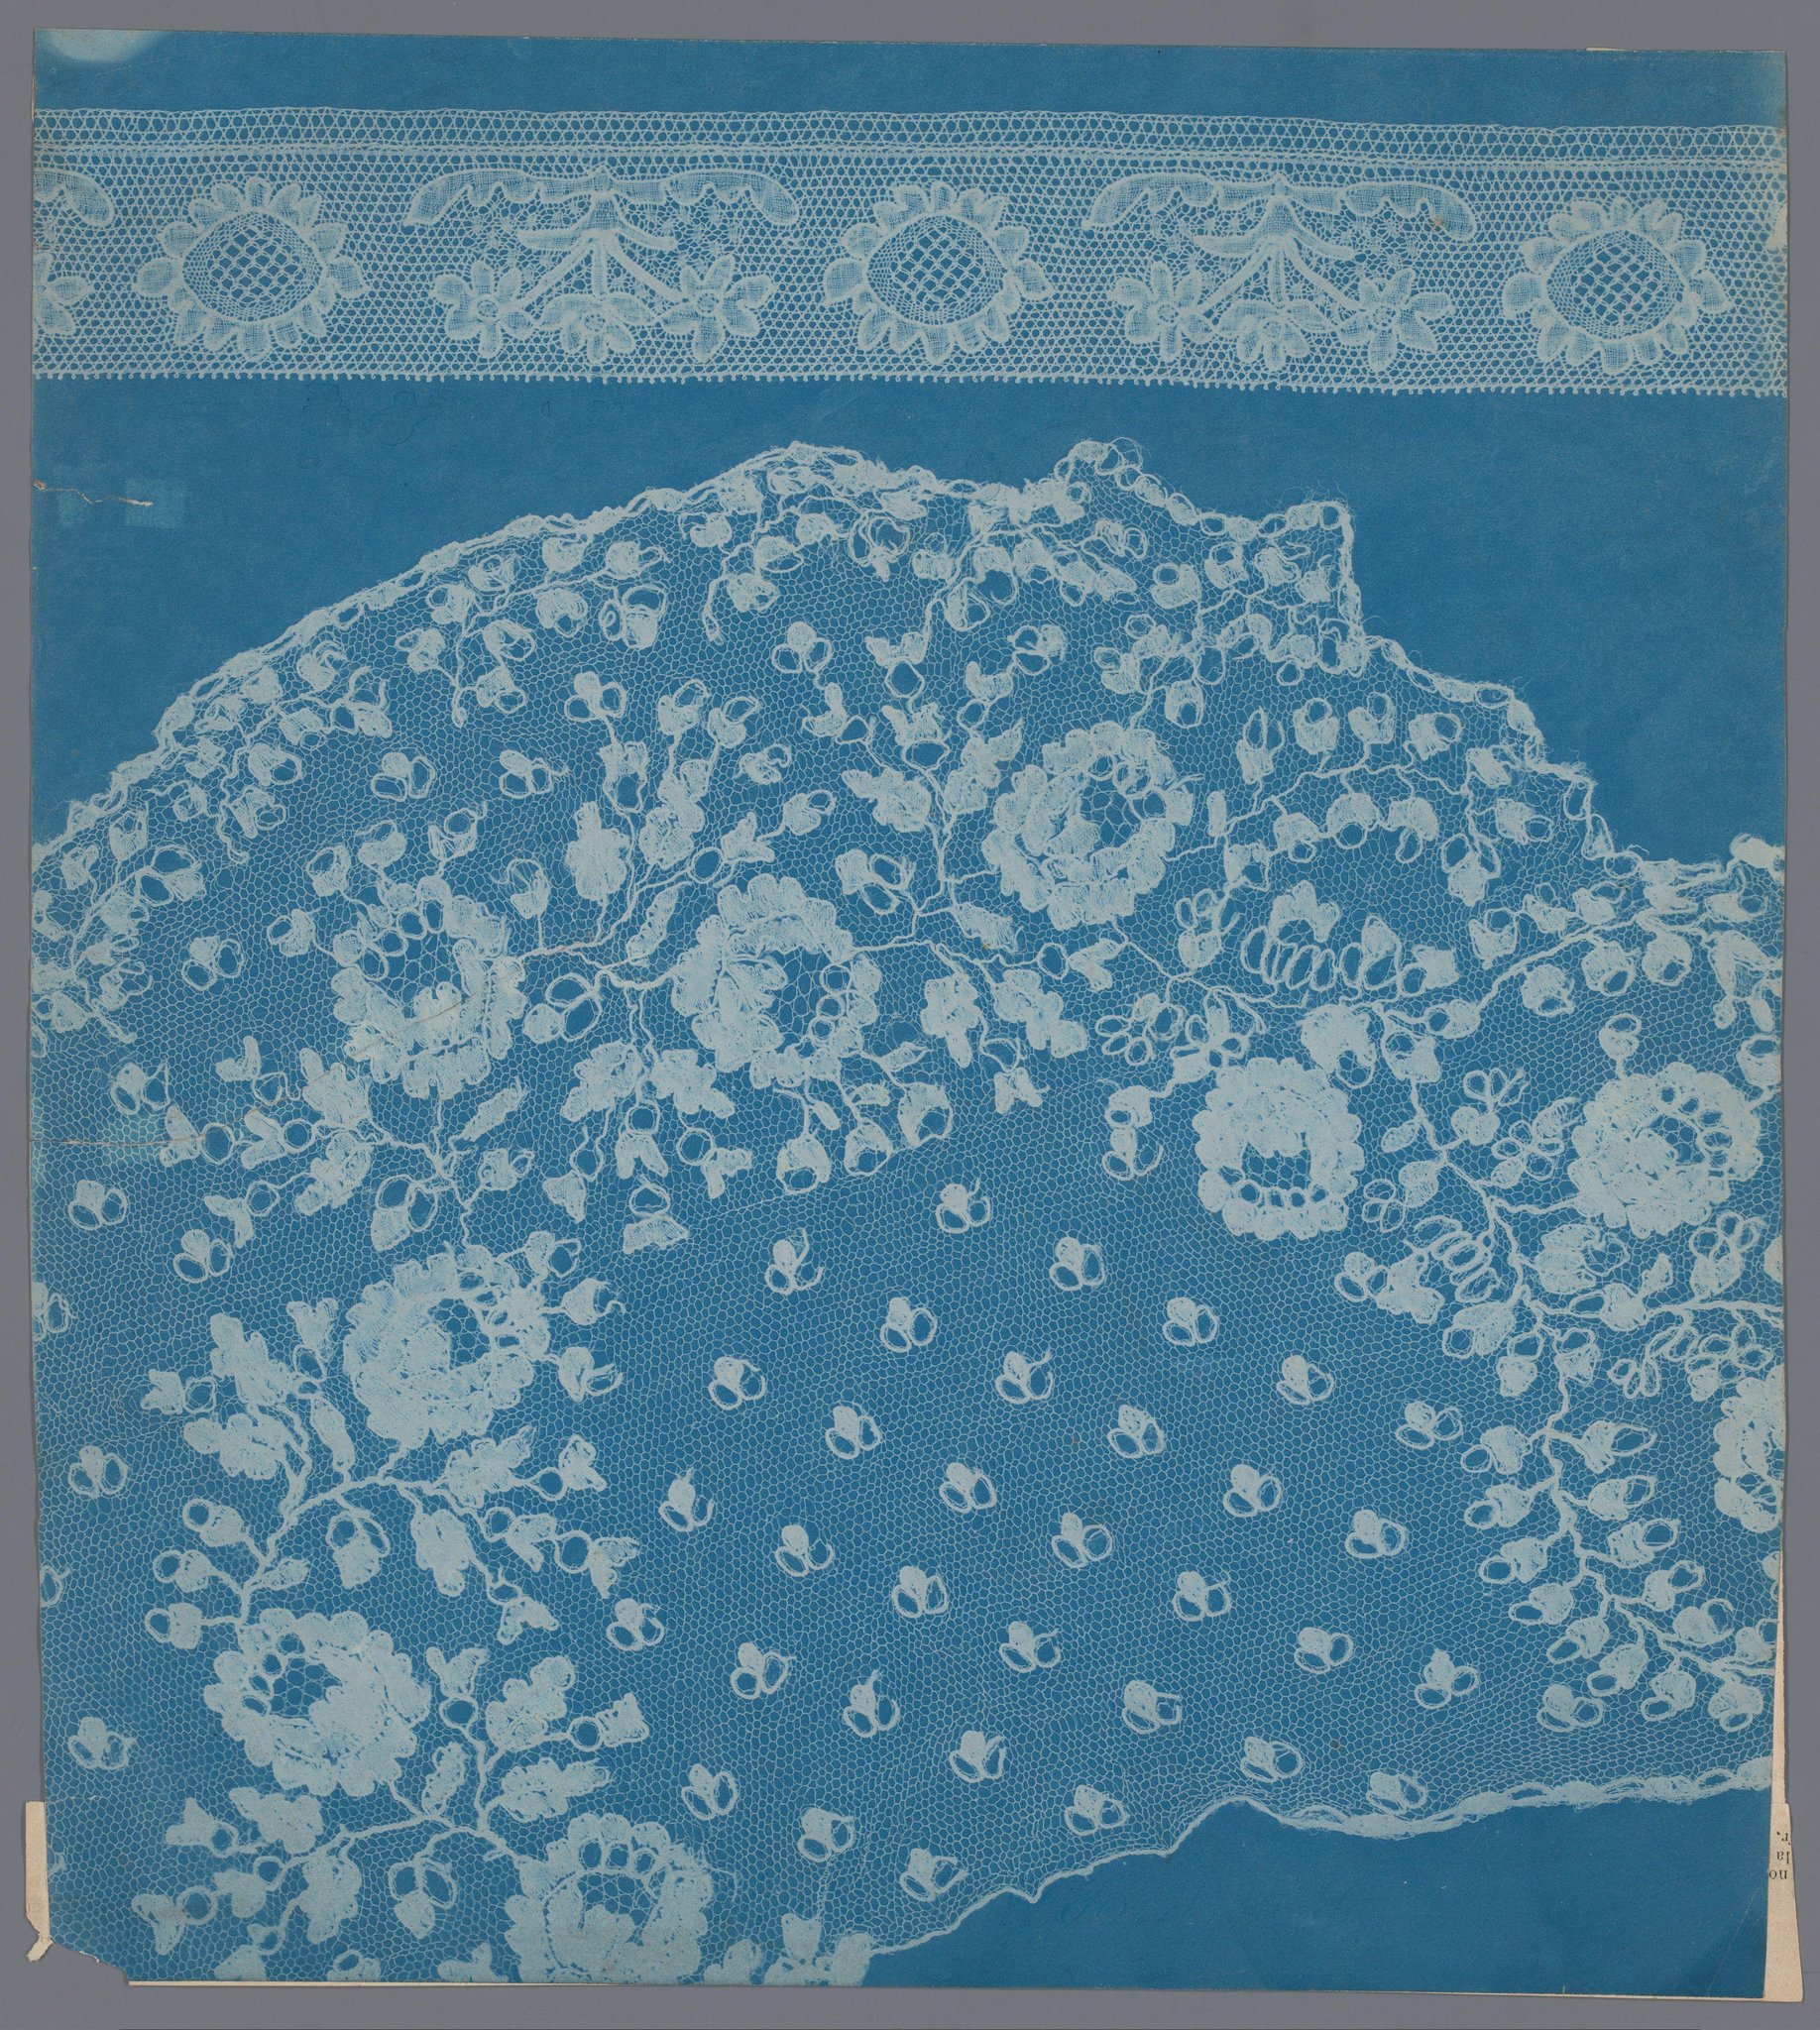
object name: photogram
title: Voorbeeld van kant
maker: Anonymous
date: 1890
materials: paper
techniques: cyanotype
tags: lace